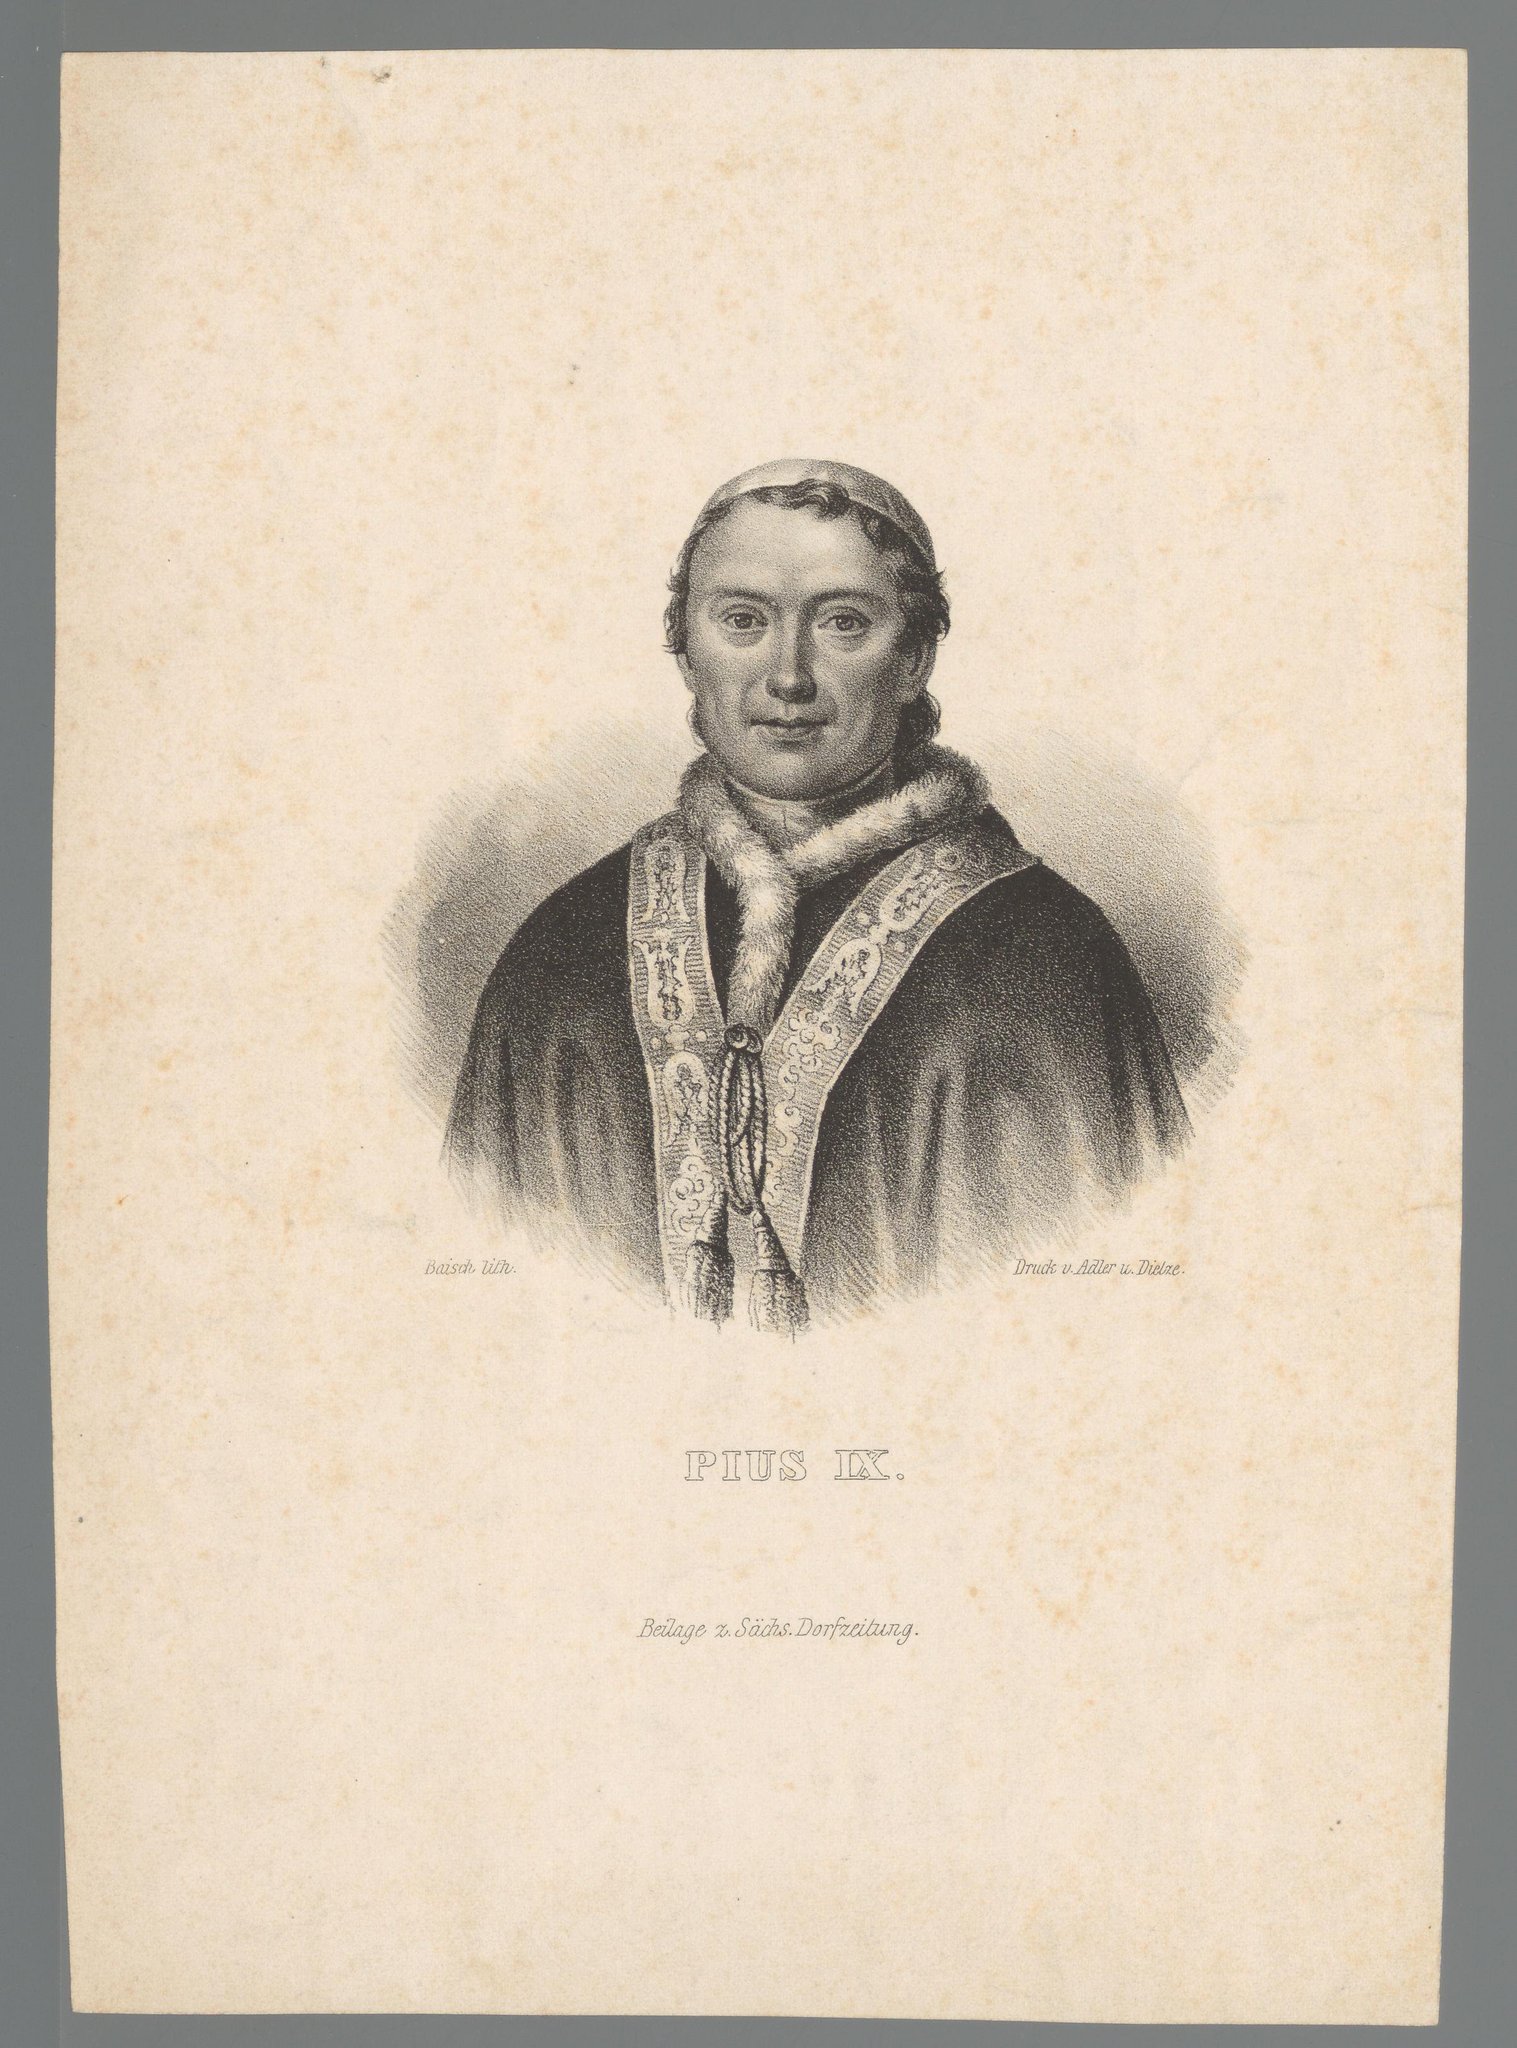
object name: print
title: Portret van Pius IX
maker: wilhelm heinrich gottlieb baisch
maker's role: print maker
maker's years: 1805-1864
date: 1815-1864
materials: paper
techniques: lithograph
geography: dresden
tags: rome, historical persons, pope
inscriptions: collector's mark: Lugt 2228